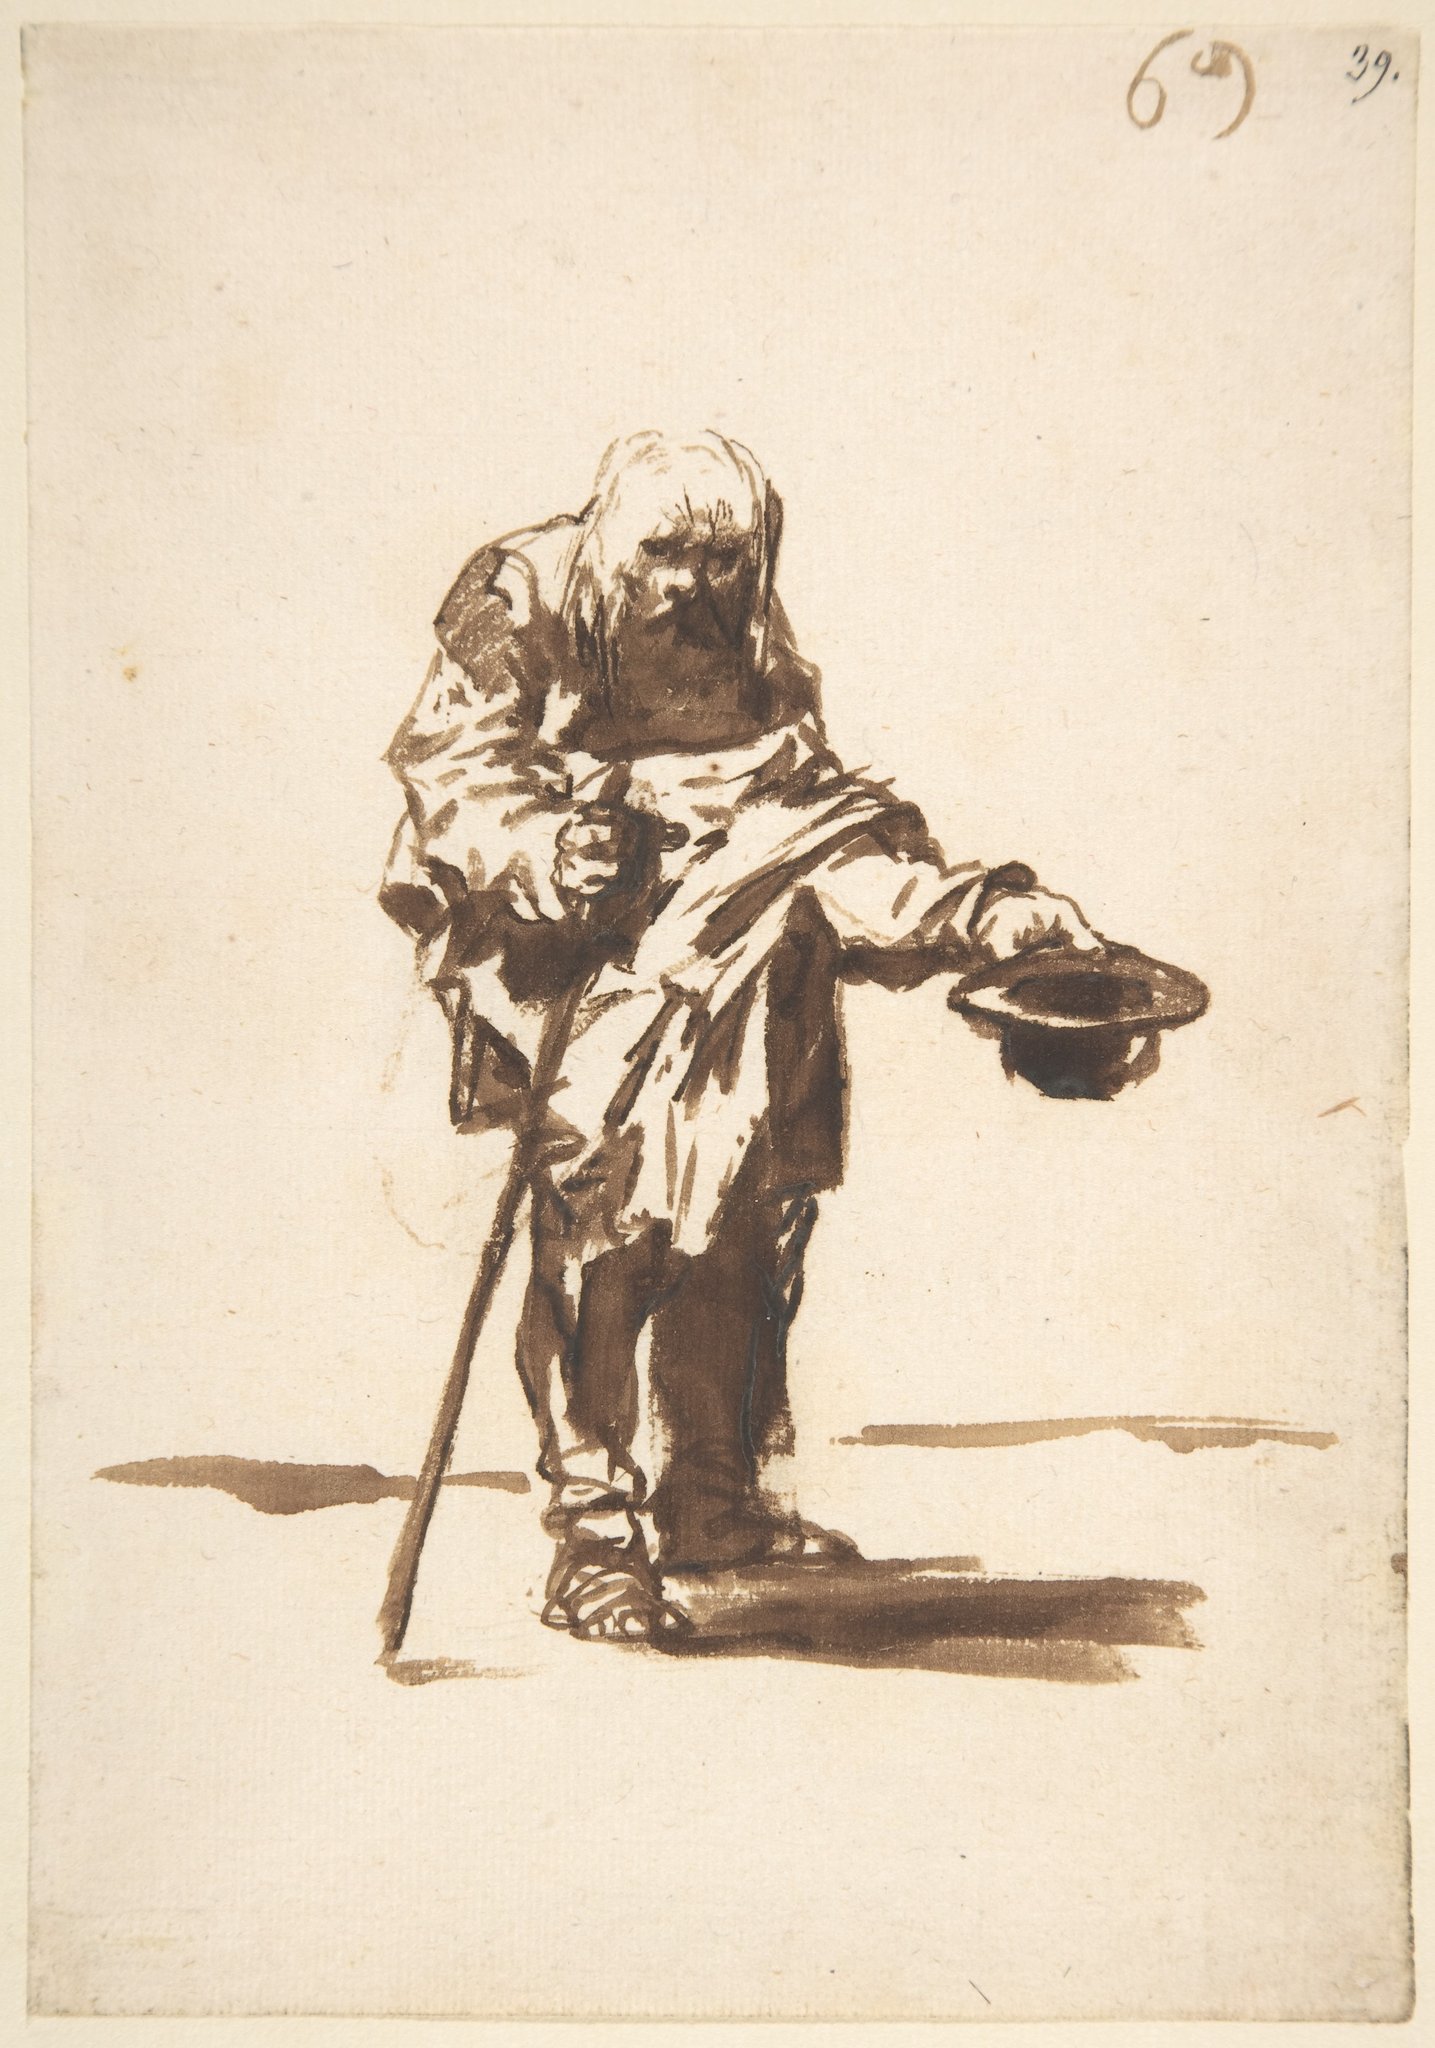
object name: drawing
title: Beggar with a staff in his right hand; folio 69 from the "Images of Spain" Album (F)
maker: goya (francisco de goya y lucientes)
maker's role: artist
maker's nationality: spanish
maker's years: 1746-1828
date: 1812-1820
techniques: brush, wash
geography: spain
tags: men